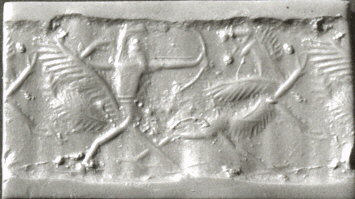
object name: cylinder seal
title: Cylinder seal with monster contest scene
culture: babylonian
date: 900-701 BCE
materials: jasper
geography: mesopotamia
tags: animals,bow and arrow,men